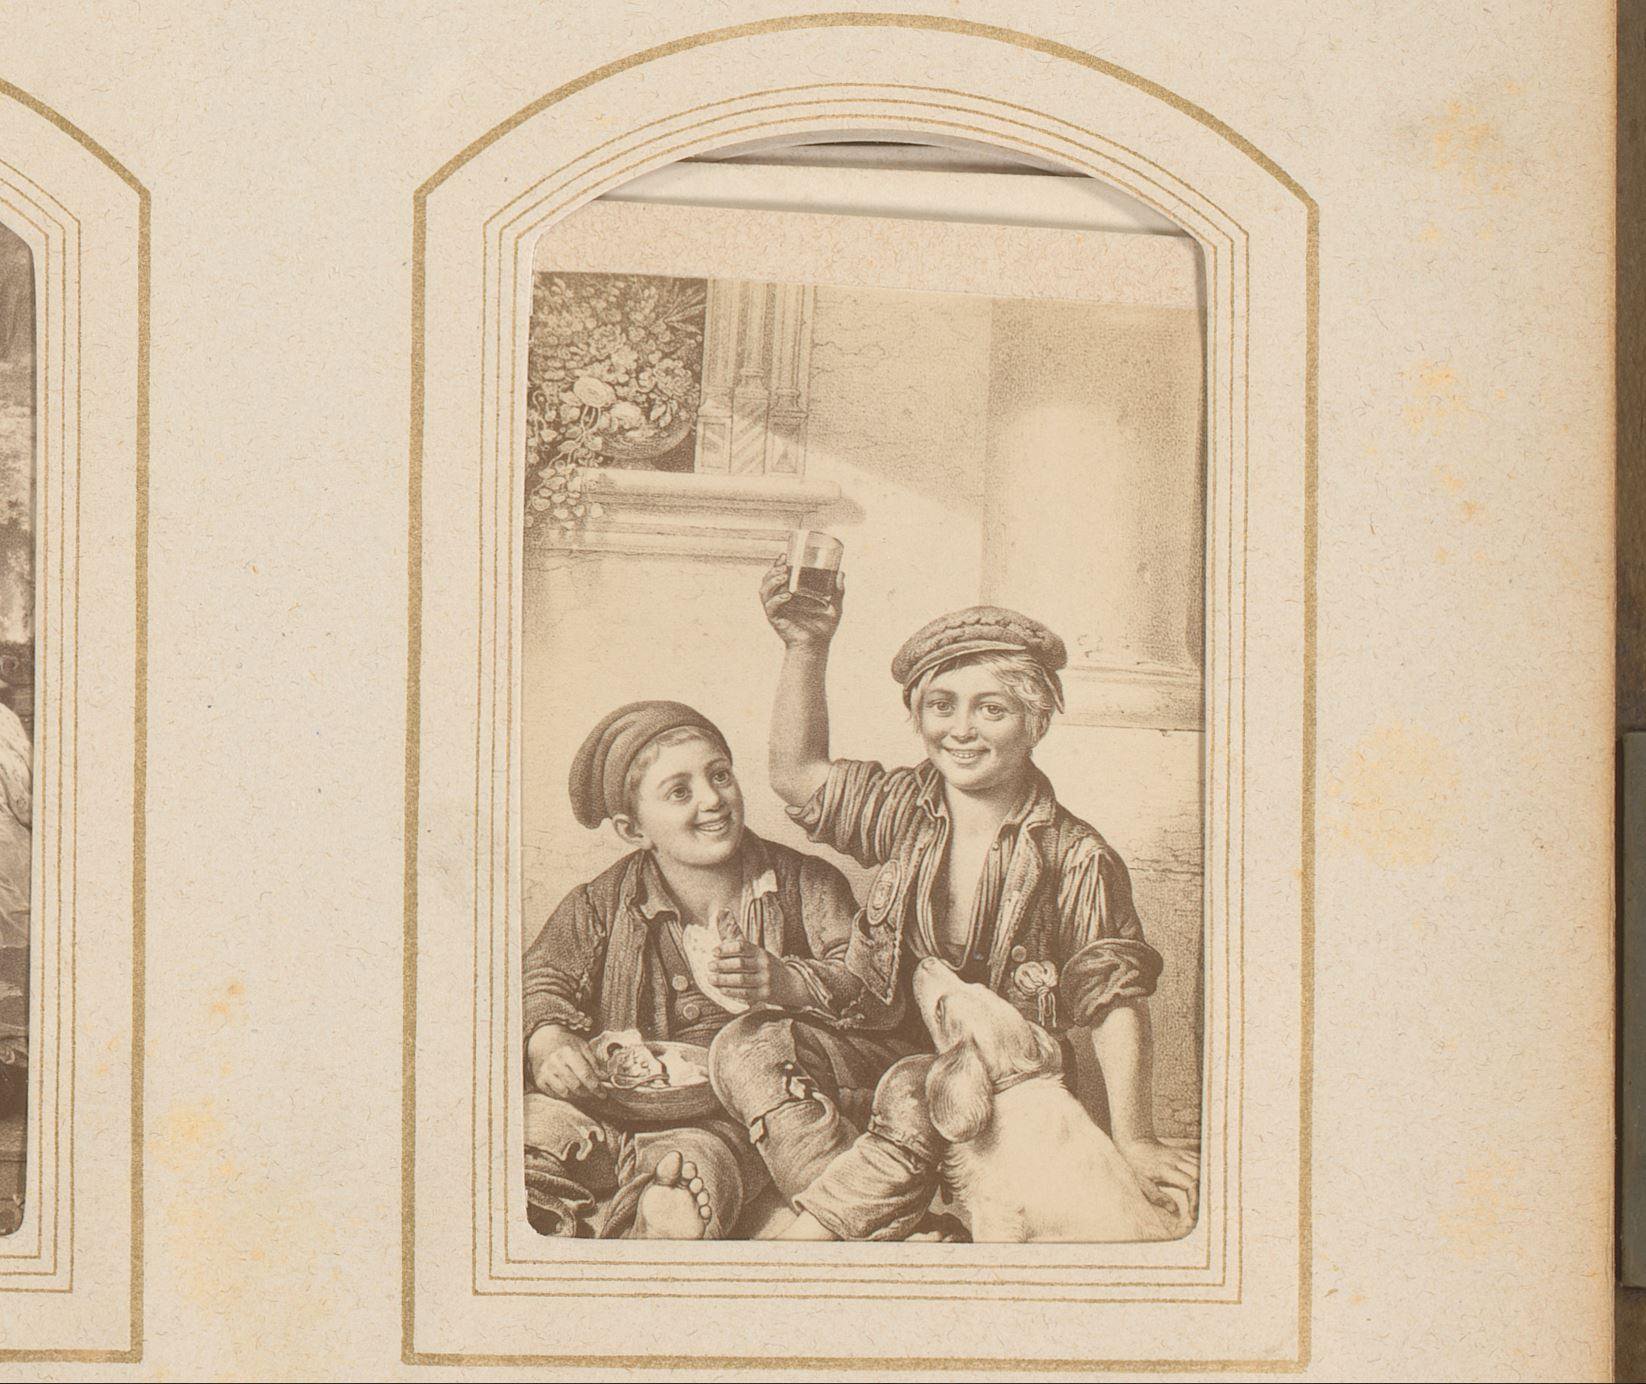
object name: reproduction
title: Fotoreproductie van Gluckliger als ein Konig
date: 1870-1890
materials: cardboard, photographic support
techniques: albumen print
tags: boy (child between toddler and youth), drinking, dog, painting, drawing and the graphic arts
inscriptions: inscription: ‘Hornung/ 717./ Plus heureux qu'un roi./ Glücklicher als ein Köning./ Happier than a king.’, annotation: ‘Glückliger als ein König!’